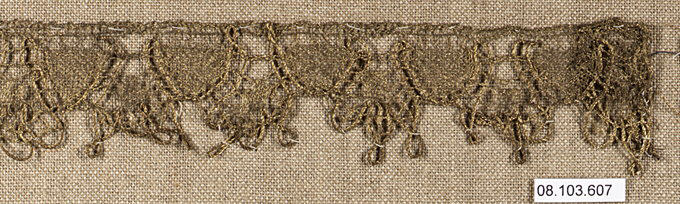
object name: piece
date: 1701-1800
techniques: lace